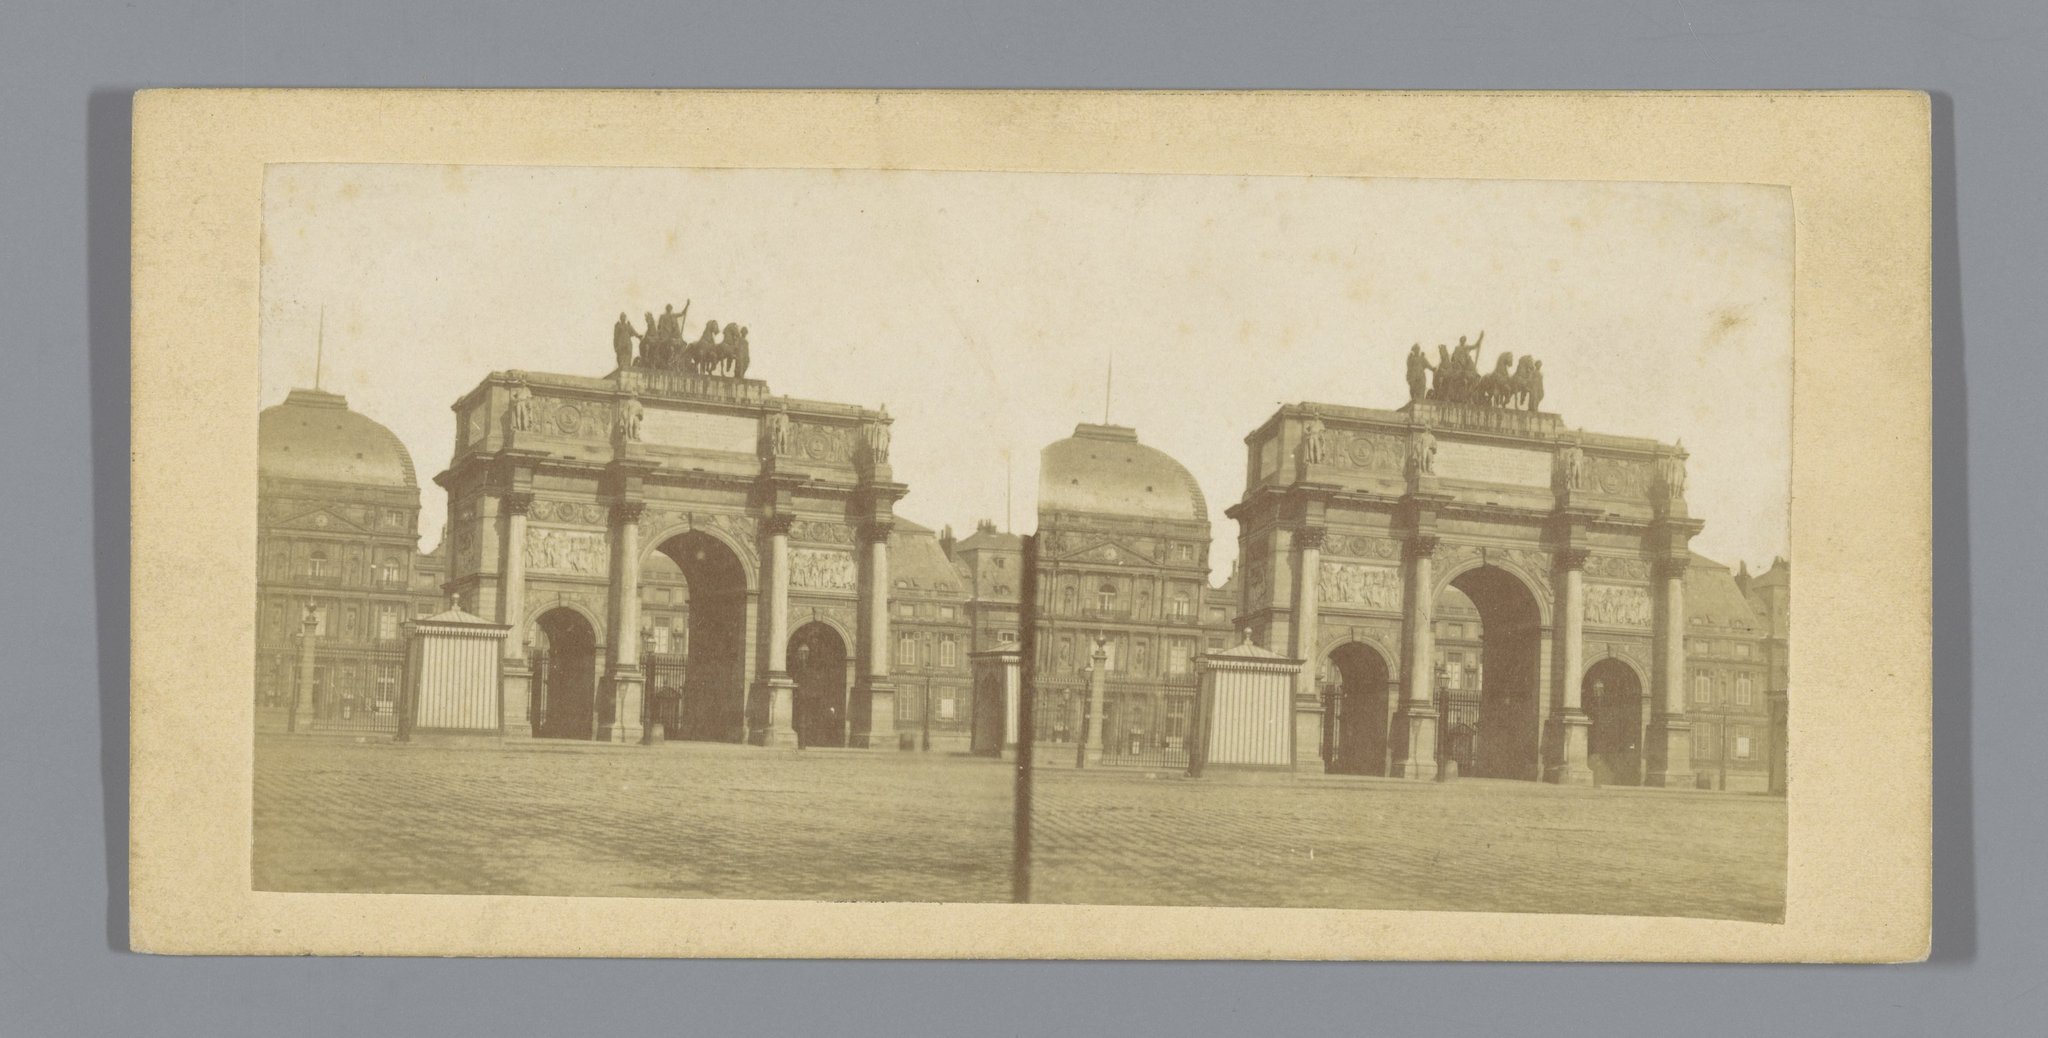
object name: stereograph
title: Arc de Triomphe du Carrousel te Parijs, met op de achtergrond het Palais des Tuileries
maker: Anonymous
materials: cardboard, photographic support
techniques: albumen print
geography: place du carrousel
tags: triumphal arch, palace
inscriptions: inscription: ‘Arc de triomphe du carrousel’